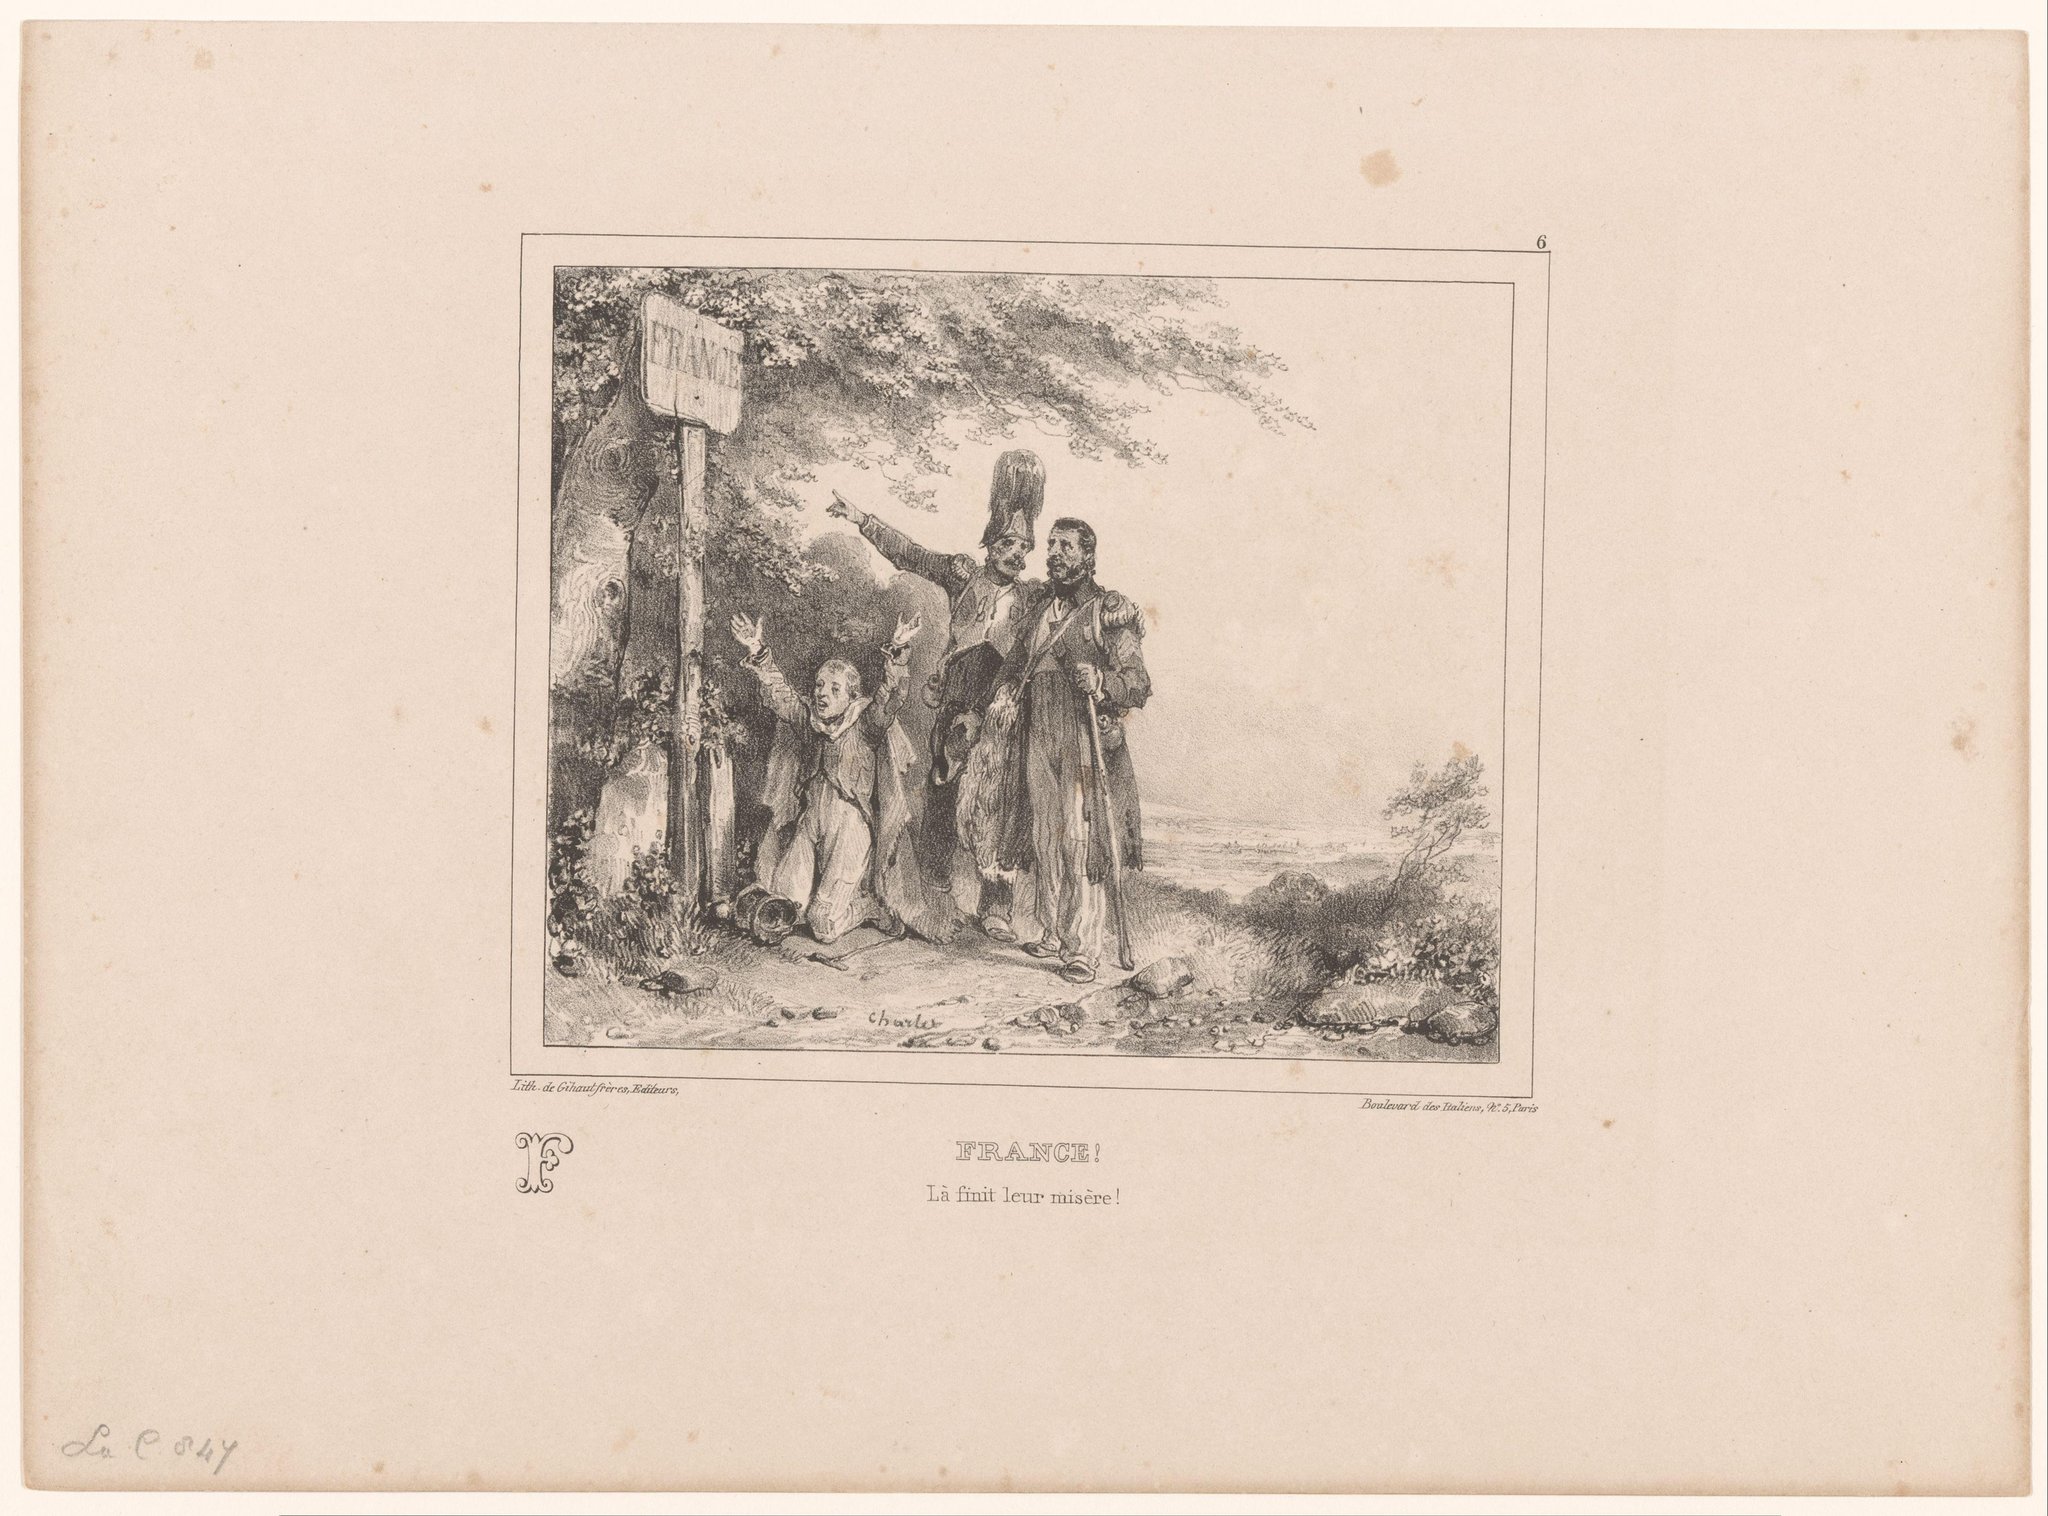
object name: print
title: F. France!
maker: nicolas toussaint charlet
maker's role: draughtsman, painter, print maker, printer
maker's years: 1792-1845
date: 1835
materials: paper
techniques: lithograph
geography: paris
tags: the soldier; the soldier's life, boundary-post, boundary-stone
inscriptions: collector's mark: Lugt 2228a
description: Drie soldaten zetten na veel ellende voor het eerst weer voet op Franse bodem.